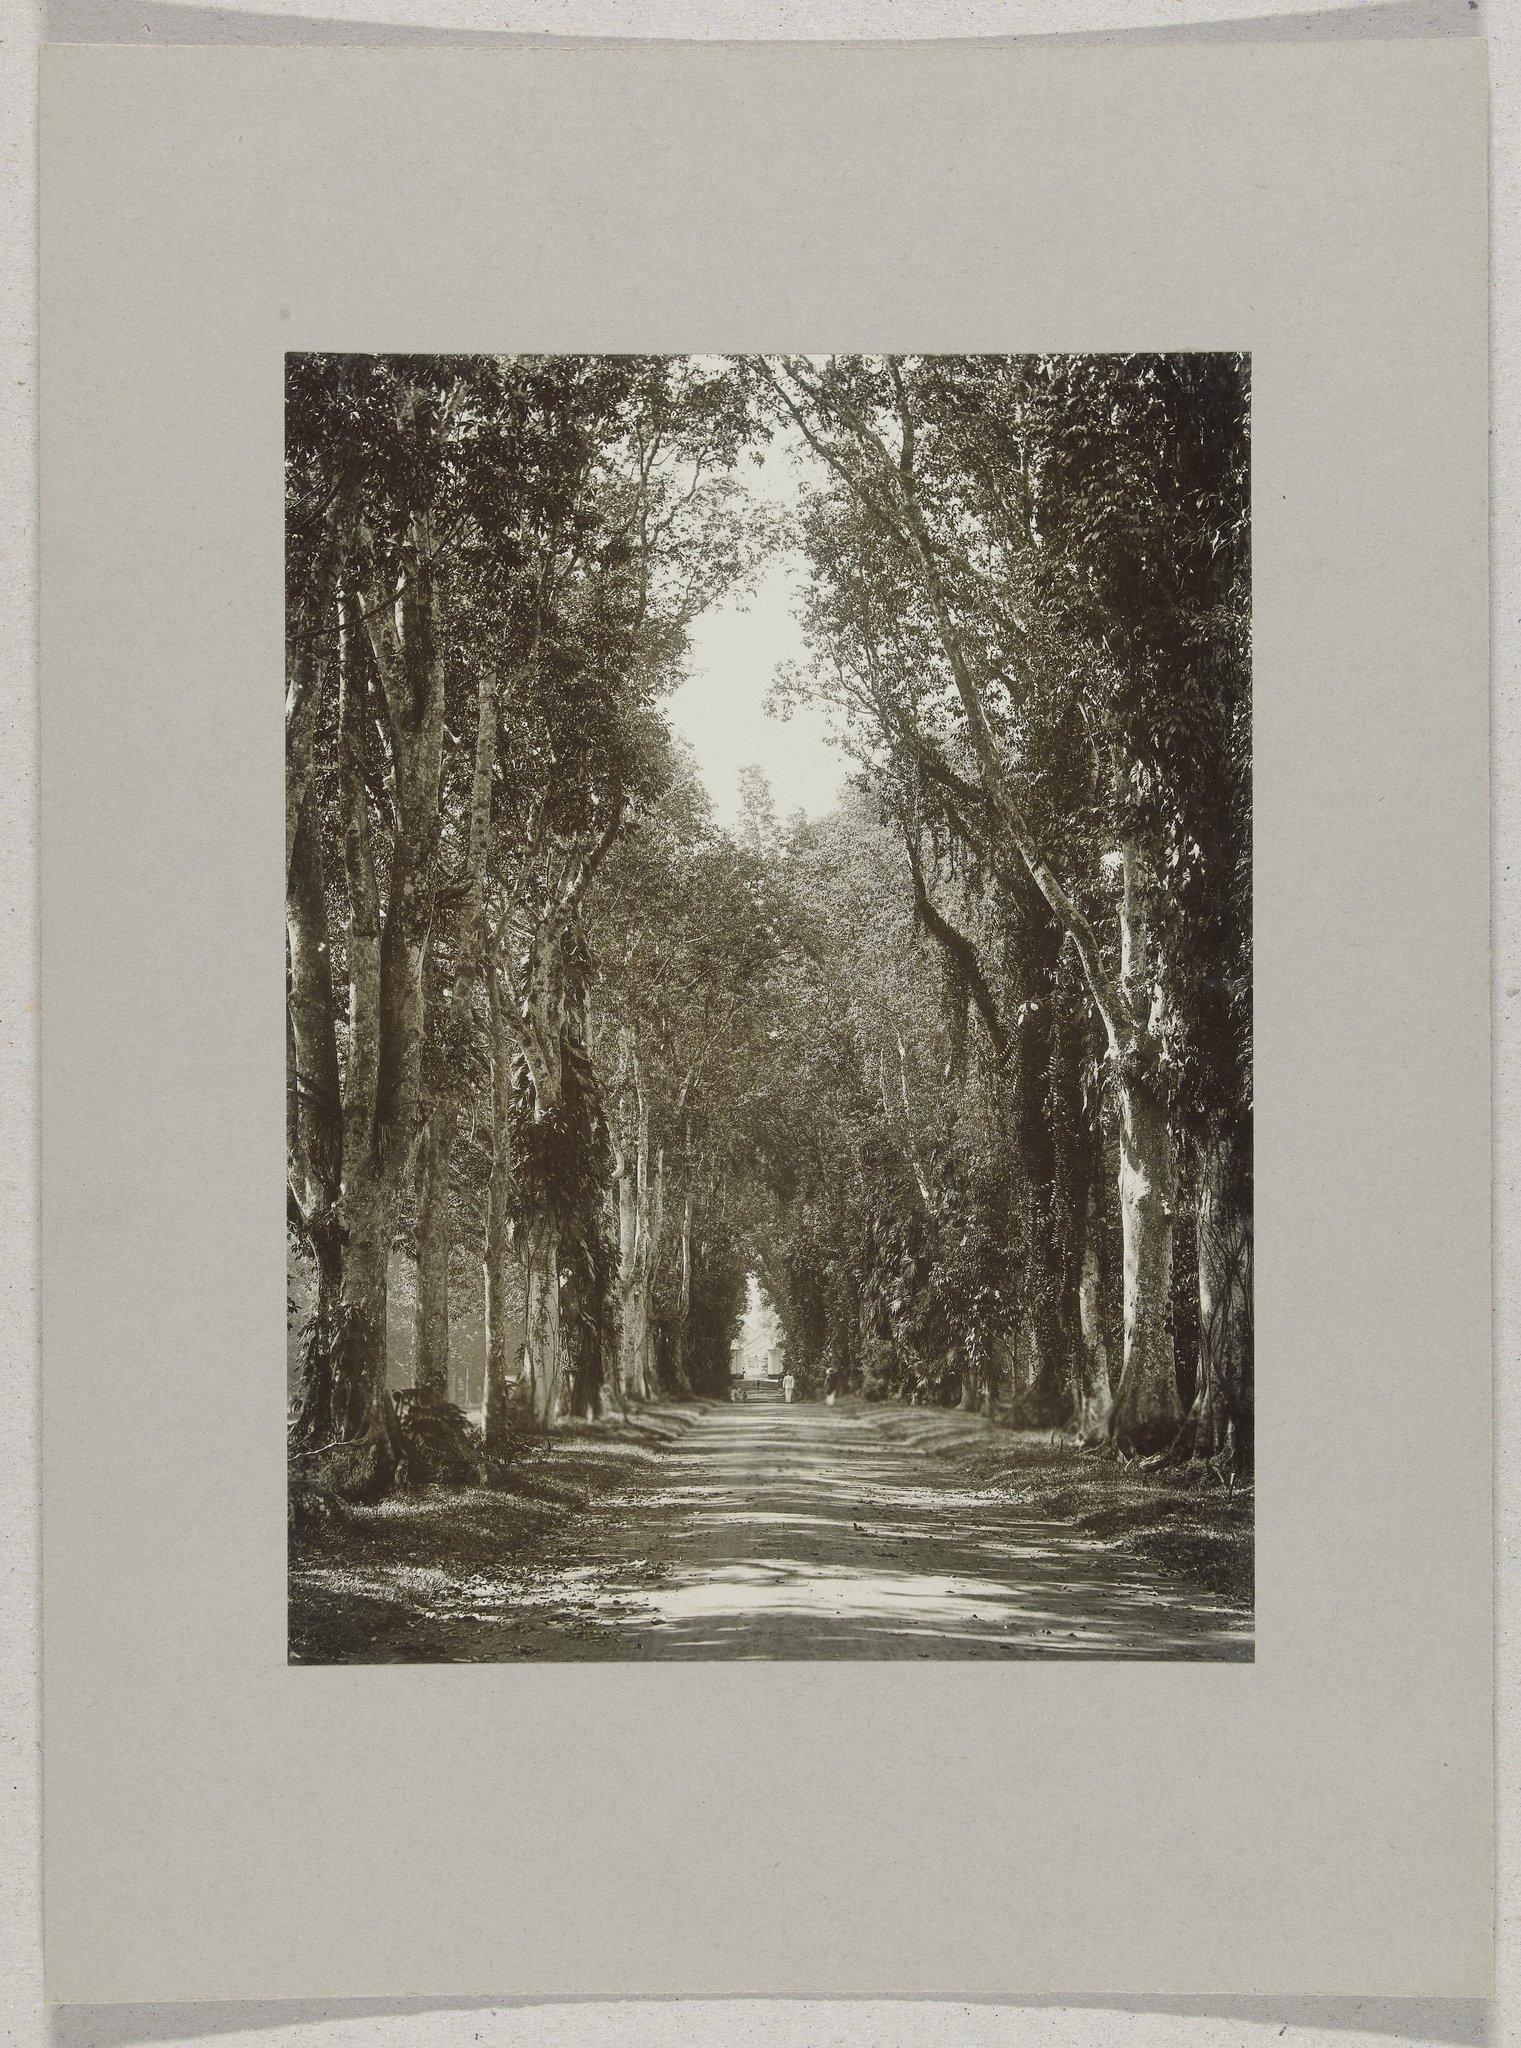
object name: photograph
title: 49. Buitenzorg. Plantentuin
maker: Anonymous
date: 1895-1915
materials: cardboard, paper, photographic support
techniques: gelatin silver print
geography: dutch east indies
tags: indonesia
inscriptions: annotation: ‘49. Buitenzorg. Plantentuin’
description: Kenarilaan in de botanische tuin te Buitenzorg (Bogor), Nederlands-Indië